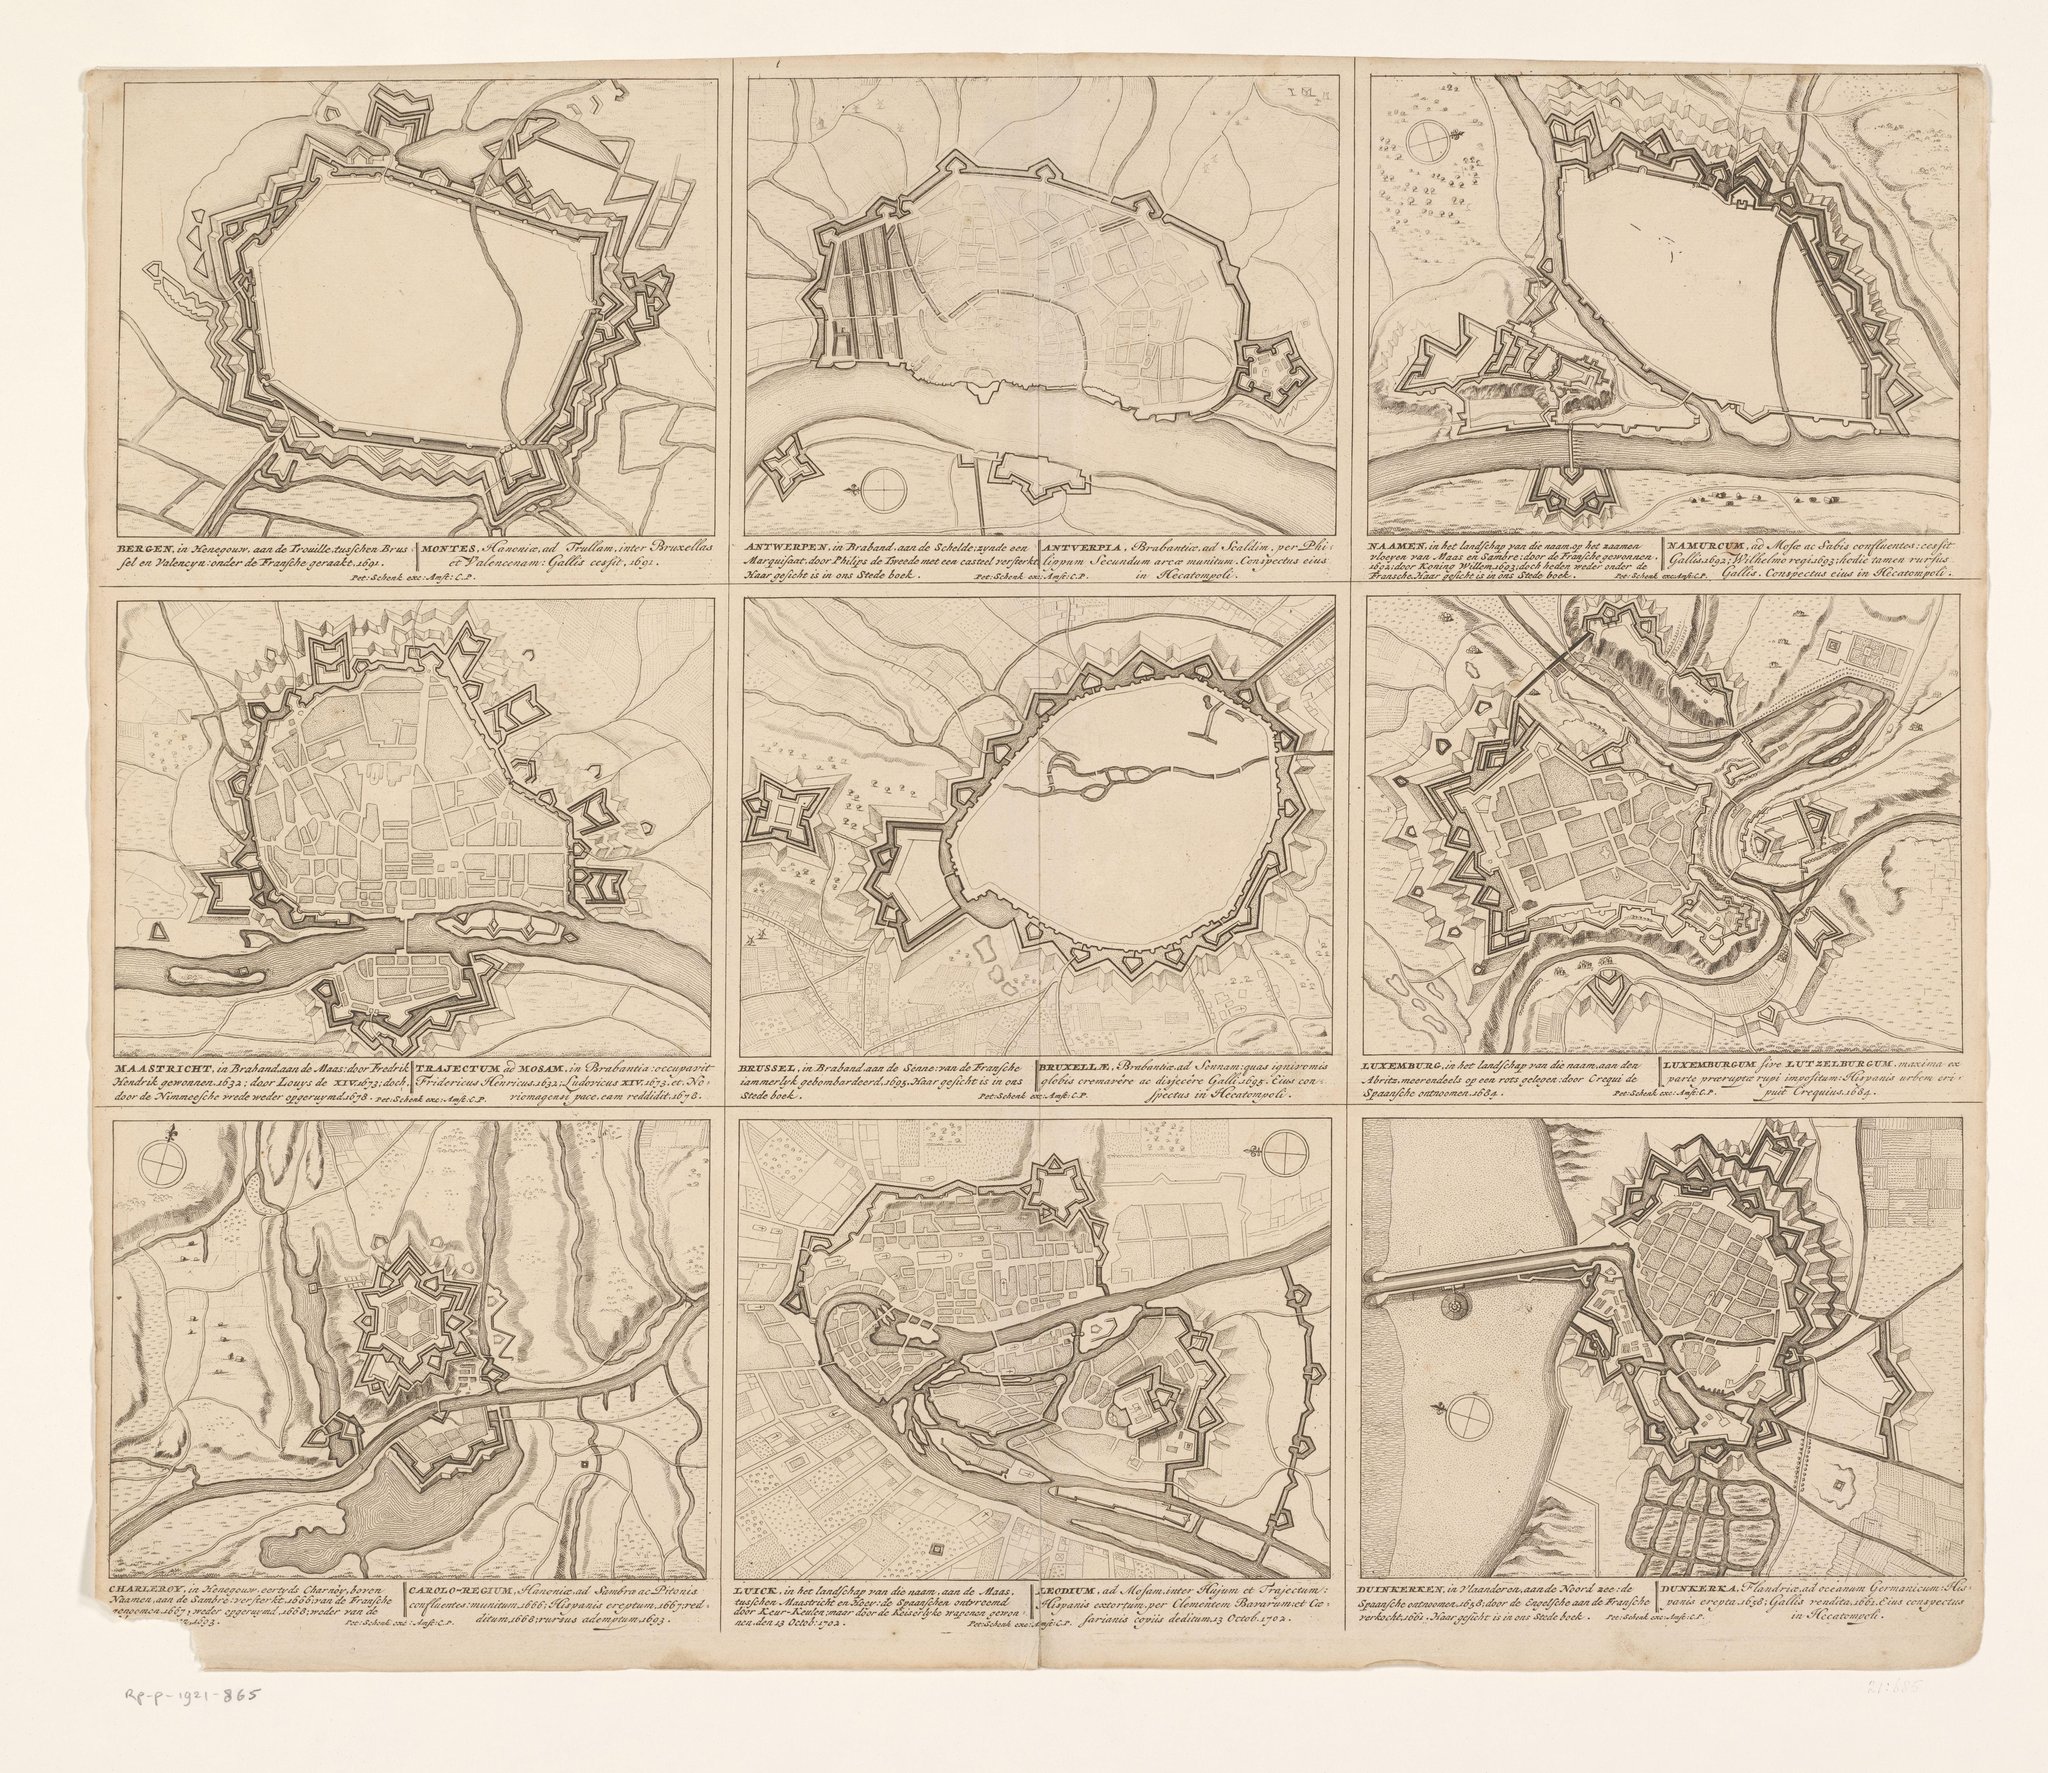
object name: area plan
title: Schouwburg van den Oorlog, Beginnende van Koning Karel den II. Tot op Koning Karel den III. Bestaande in IX. Historische Figuren op een Olifants Blad, als Veldslagen, Belegeringen te Water en te Lande, met de voornaamste Vestingen (...)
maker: pieter schenk (i)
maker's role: print maker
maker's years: 1660-1711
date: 1700-1710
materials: paper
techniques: etching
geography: amsterdam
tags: fortress, maps of cities, antwerp, liège, brussels, maastricht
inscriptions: inscription: ‘F 17’, collector's mark: Lugt 2233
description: Prent uit de serie: Schouwburg van den Oorlog, Beginnende van Koning Karel den II. Tot op Koning Karel den III. Bestaande in IX. Historische Figuren op een Olifants Blad, als Veldslagen, Belegeringen te Water en te Lande, met de voornaamste Vestingen (...). Amsterdam: Pieter Schenk, [ca. 1710]. Of latere uitgave.